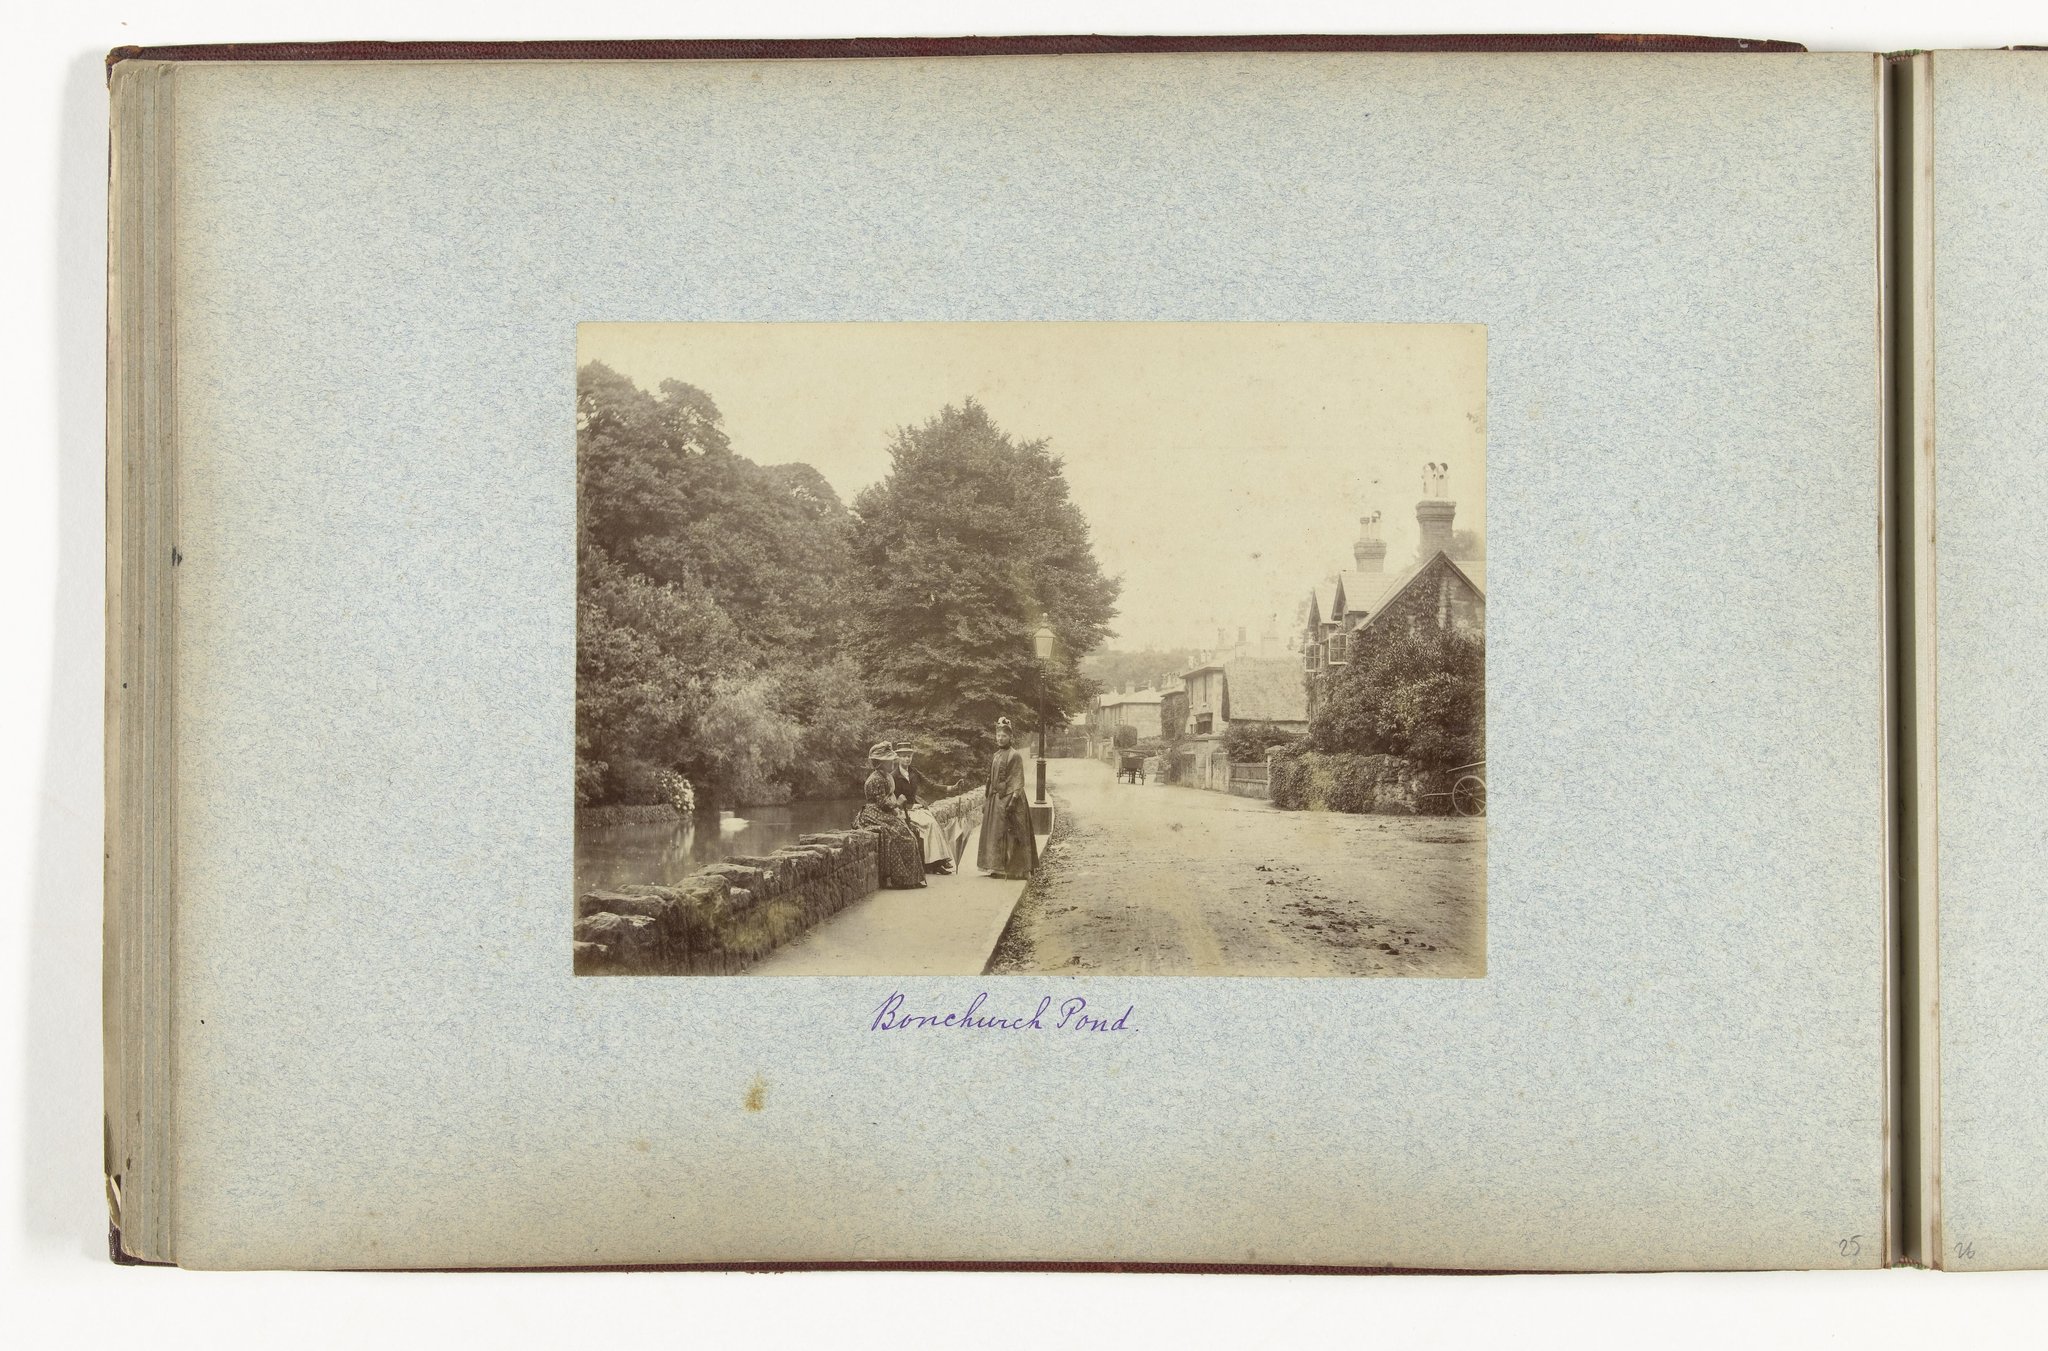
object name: album leaf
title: Drie vrouwen op straat langs de Bonchurch Pond, Bonchurch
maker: henry pauw van wieldrecht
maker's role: fotograaf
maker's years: 1863-1912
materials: cardboard, paper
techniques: albumen print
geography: bonchurch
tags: street